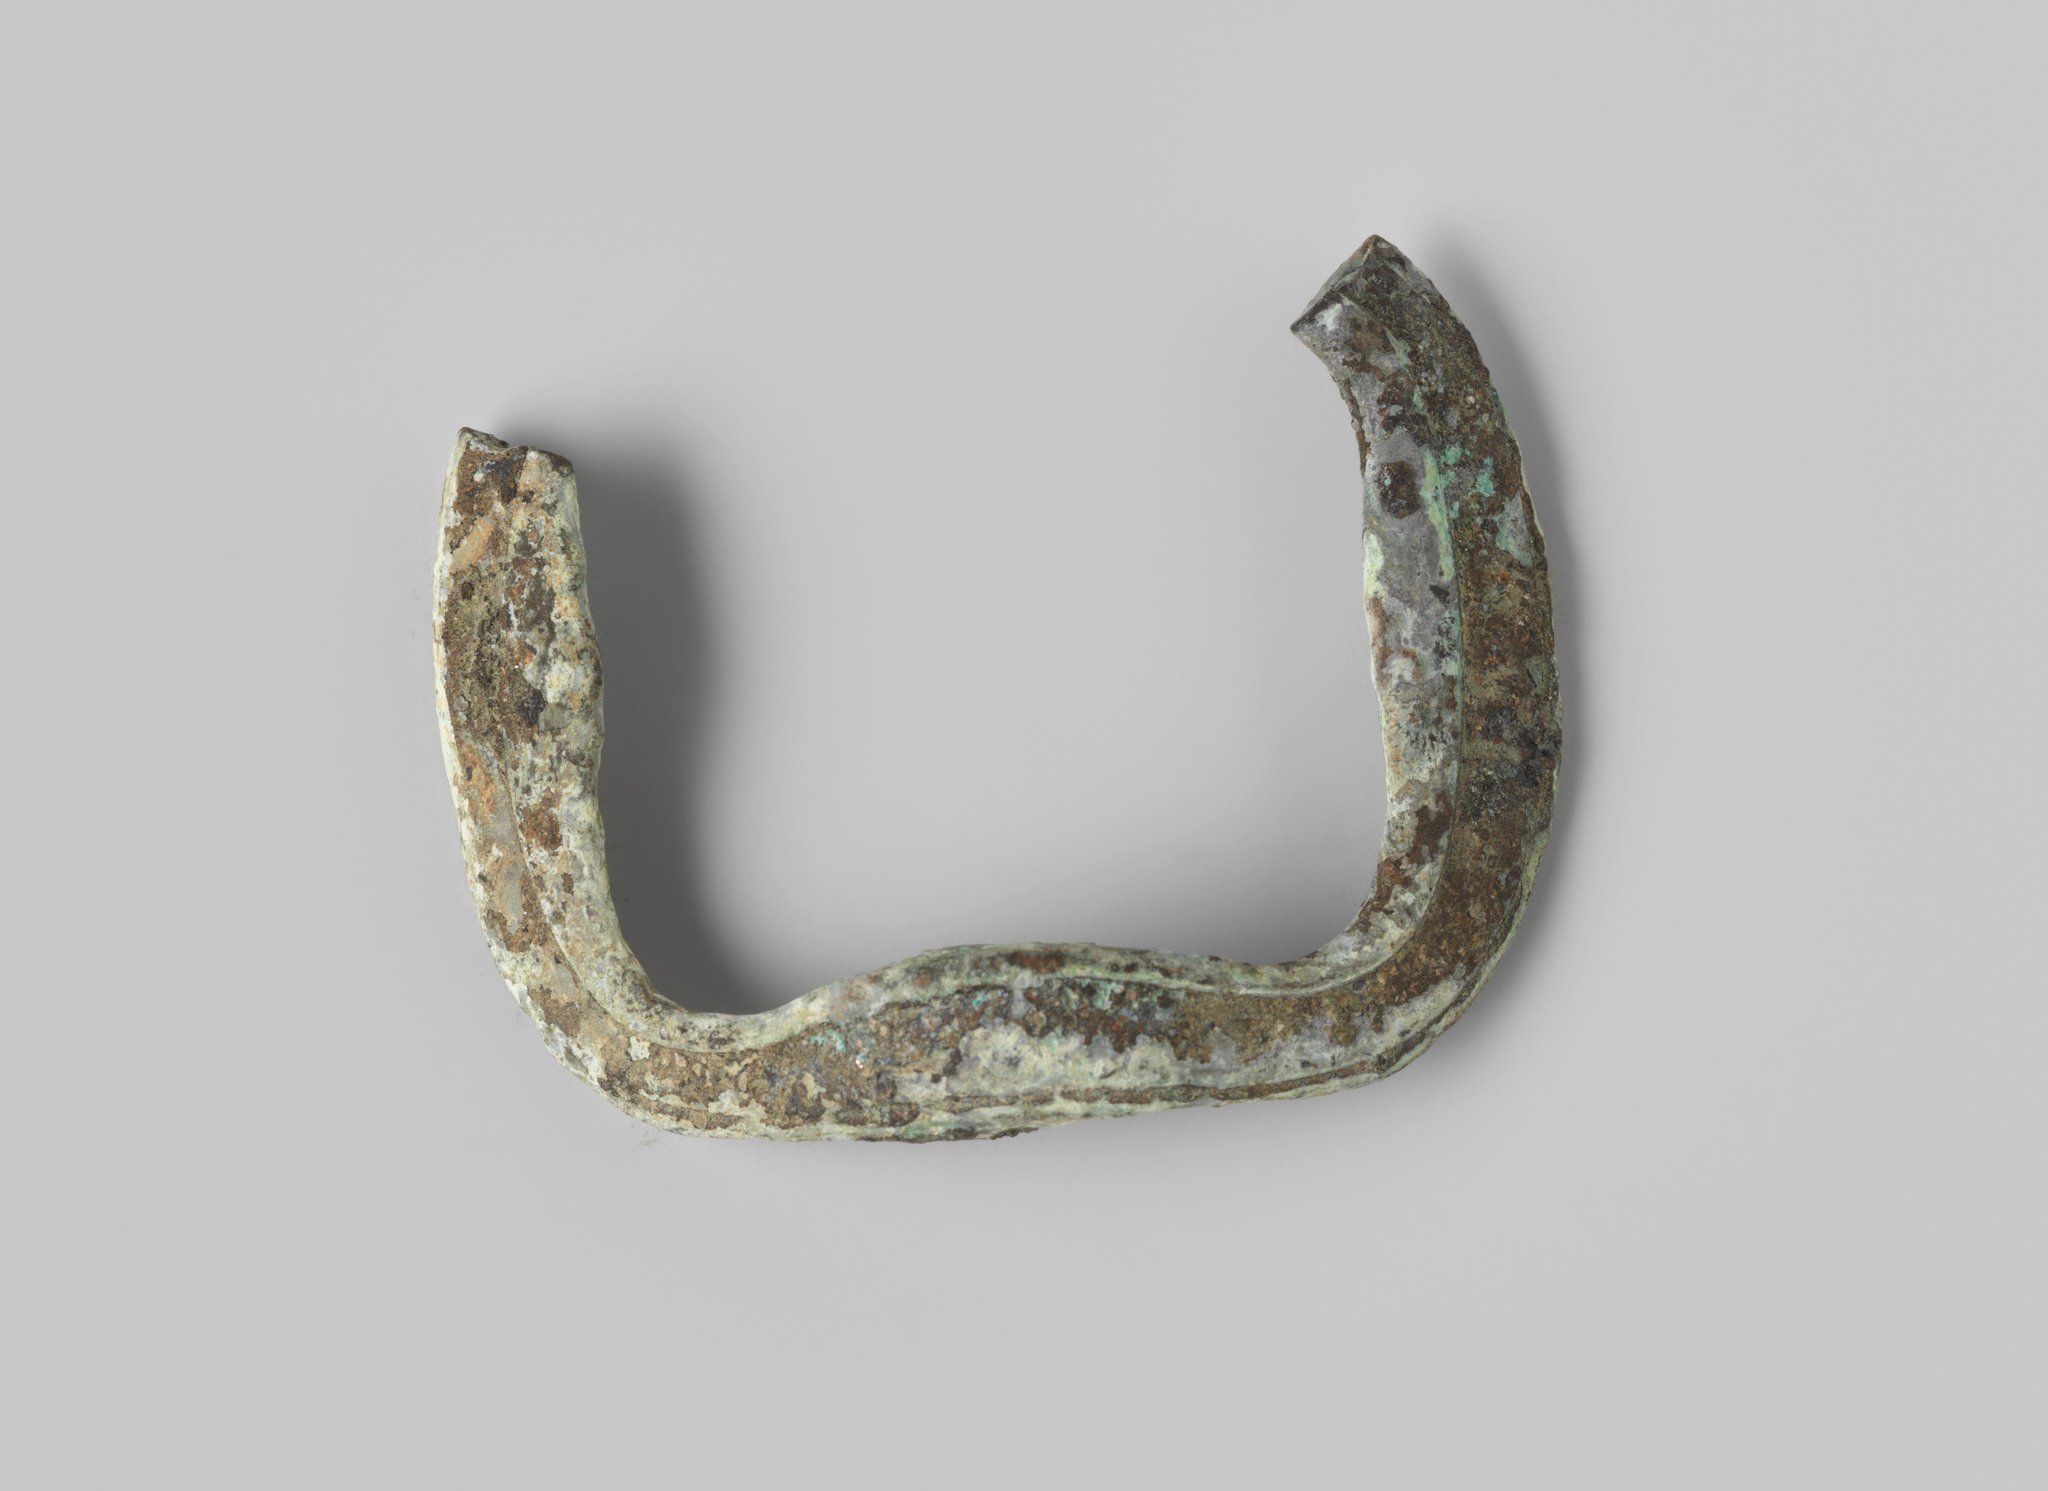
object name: shoe buckle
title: Fragment schoengesp uit het wrak van de Oost-Indiëvaarder Hollandia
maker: Anonymous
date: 1700-1743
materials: copper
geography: netherlands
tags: verenigde oostindische compagnie, hollandia (schip), annet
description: Buckle, chape buckle, shoe buckle; fragment of ring, id. NG 1980-27H2104.